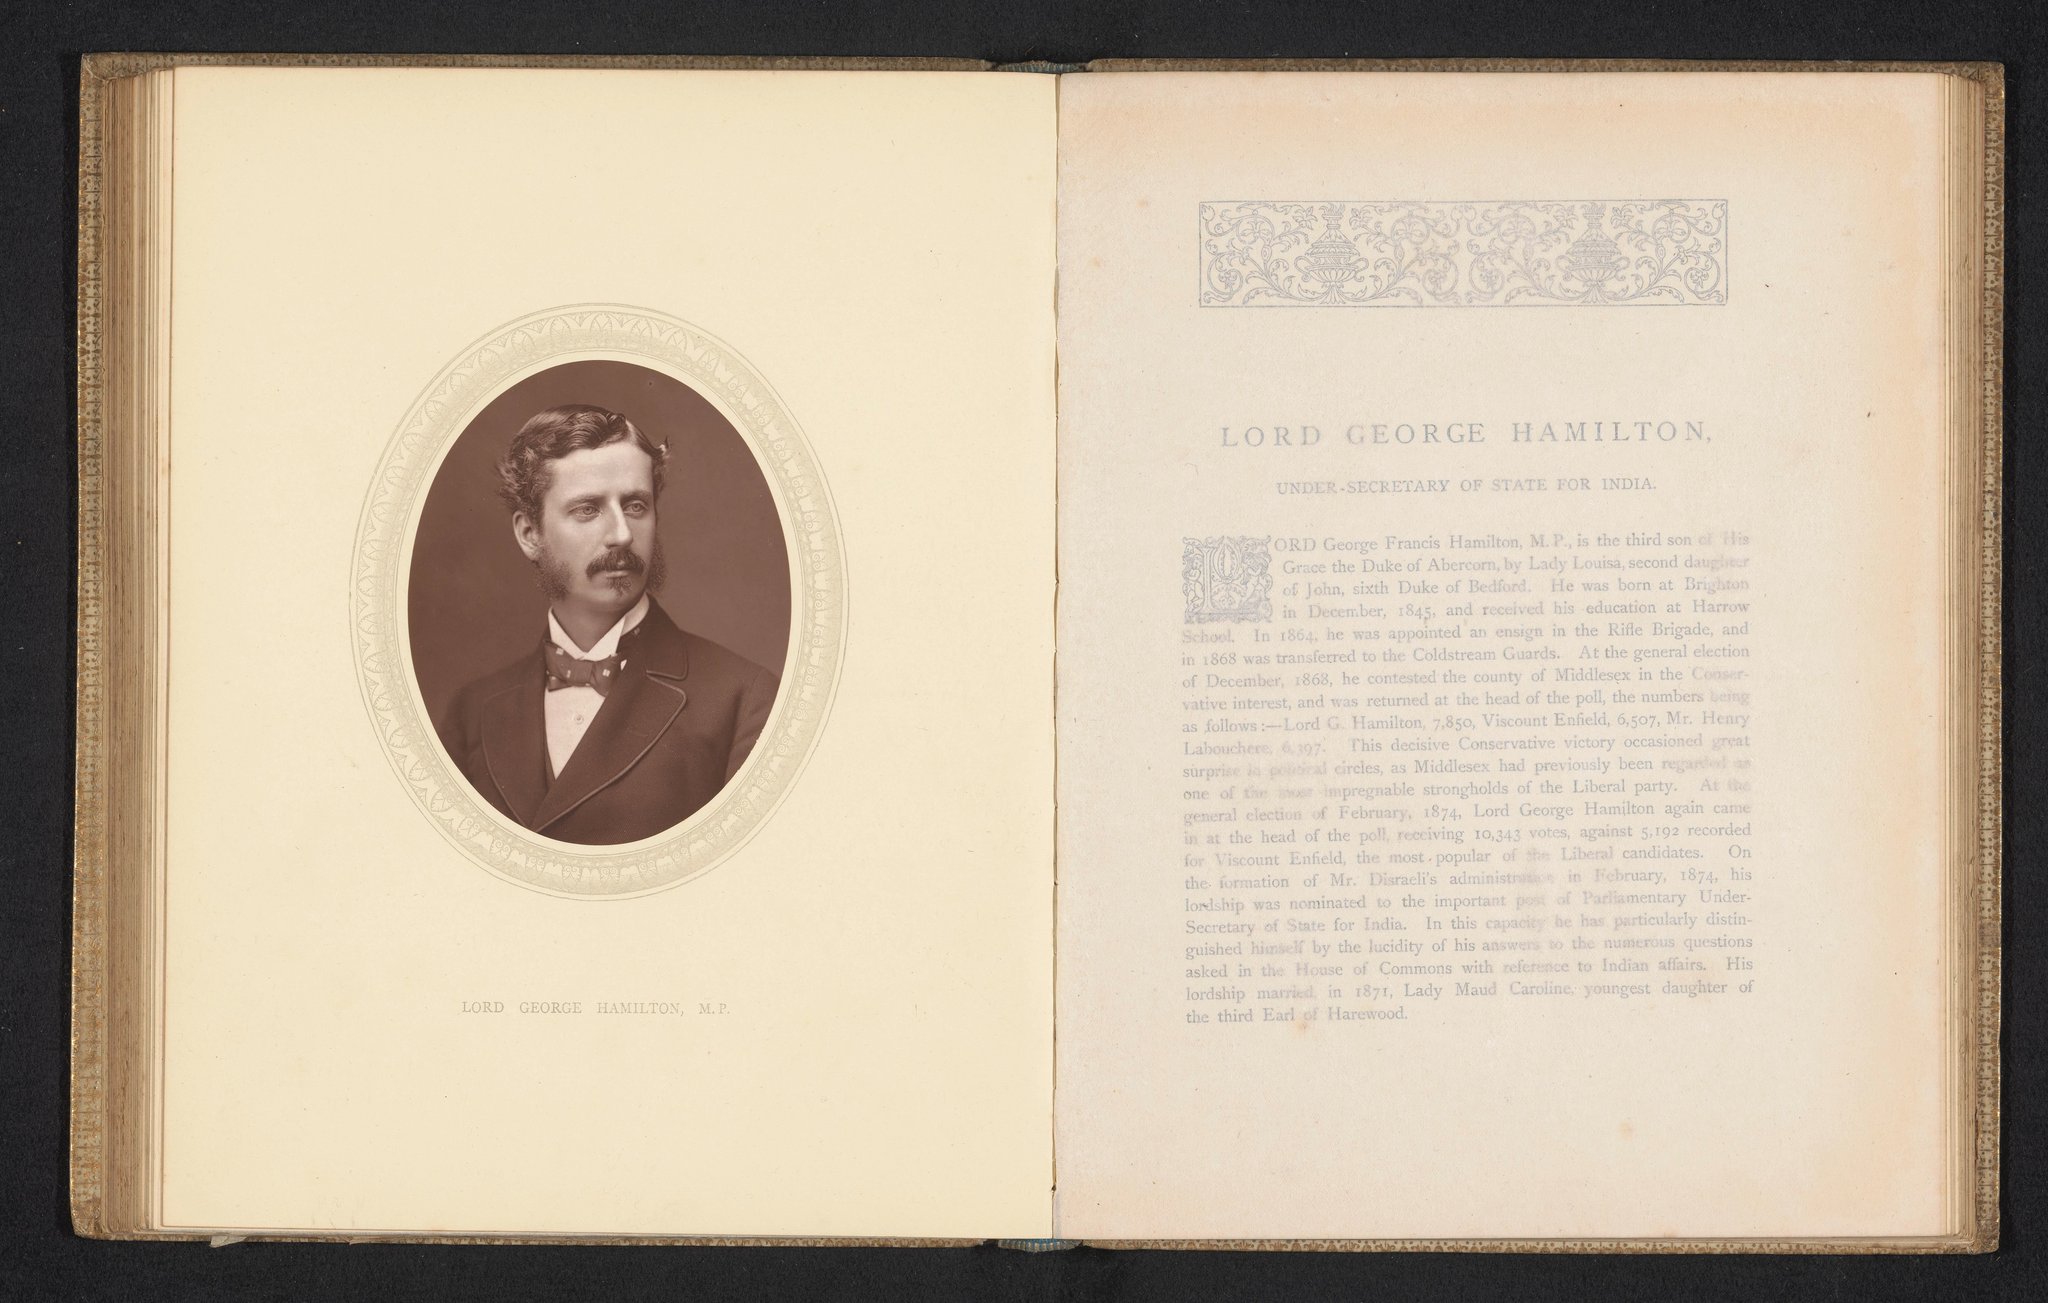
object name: page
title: Lord George Hamilton, M.P.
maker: Anonymous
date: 1871-1876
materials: paper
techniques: woodburytype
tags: politician, historical persons (portraits and scenes from the life) (+ (full) bust portrait), politician, e.g. party leader